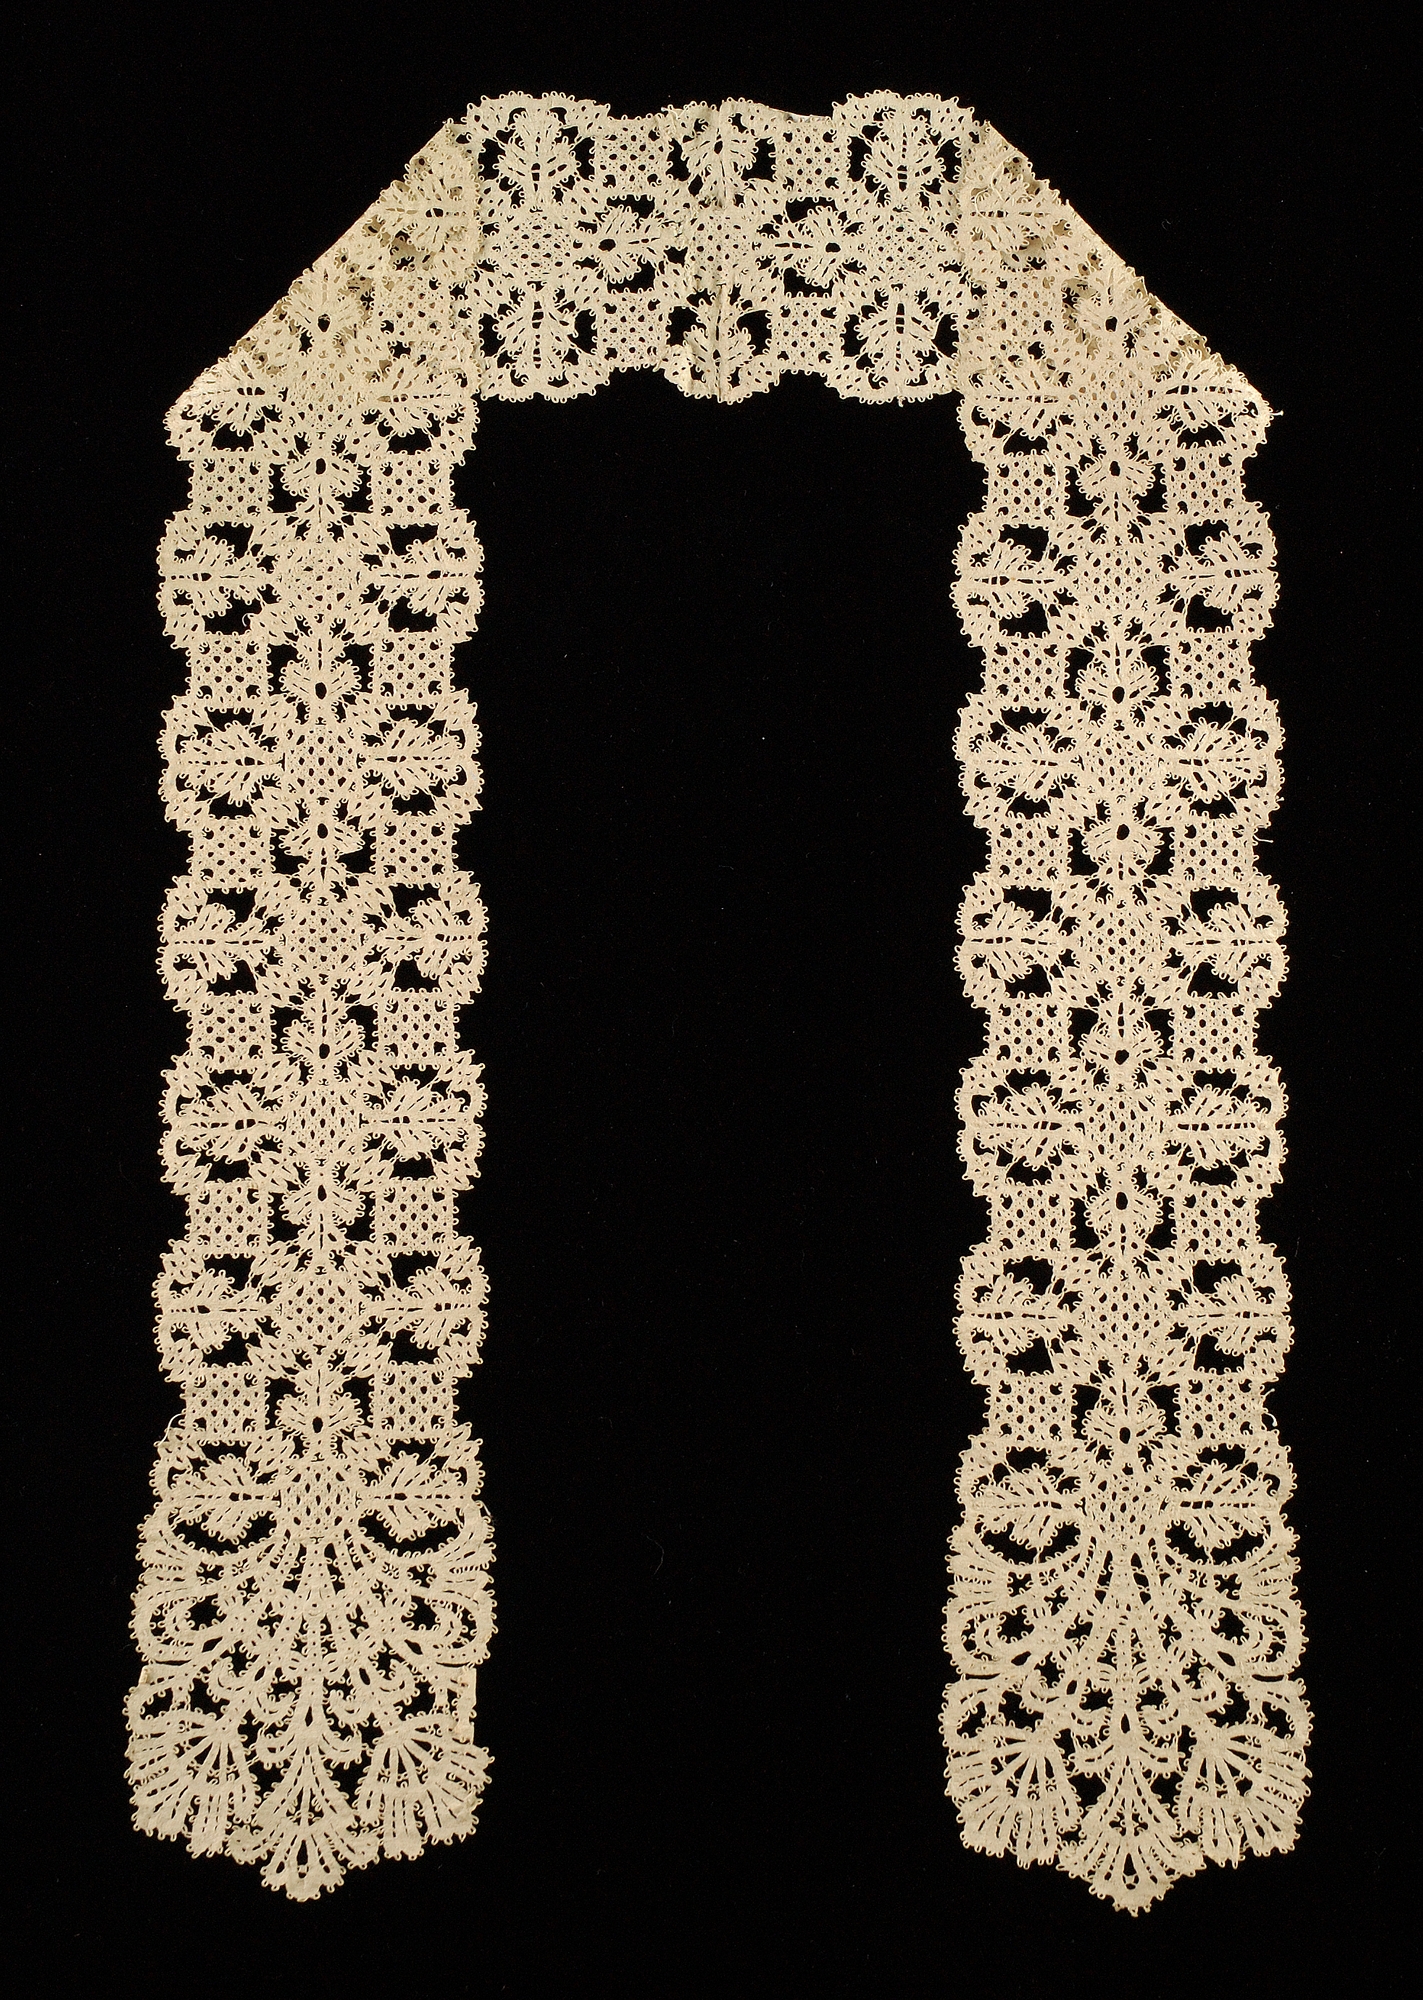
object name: lappet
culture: european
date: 1701-1733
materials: linen